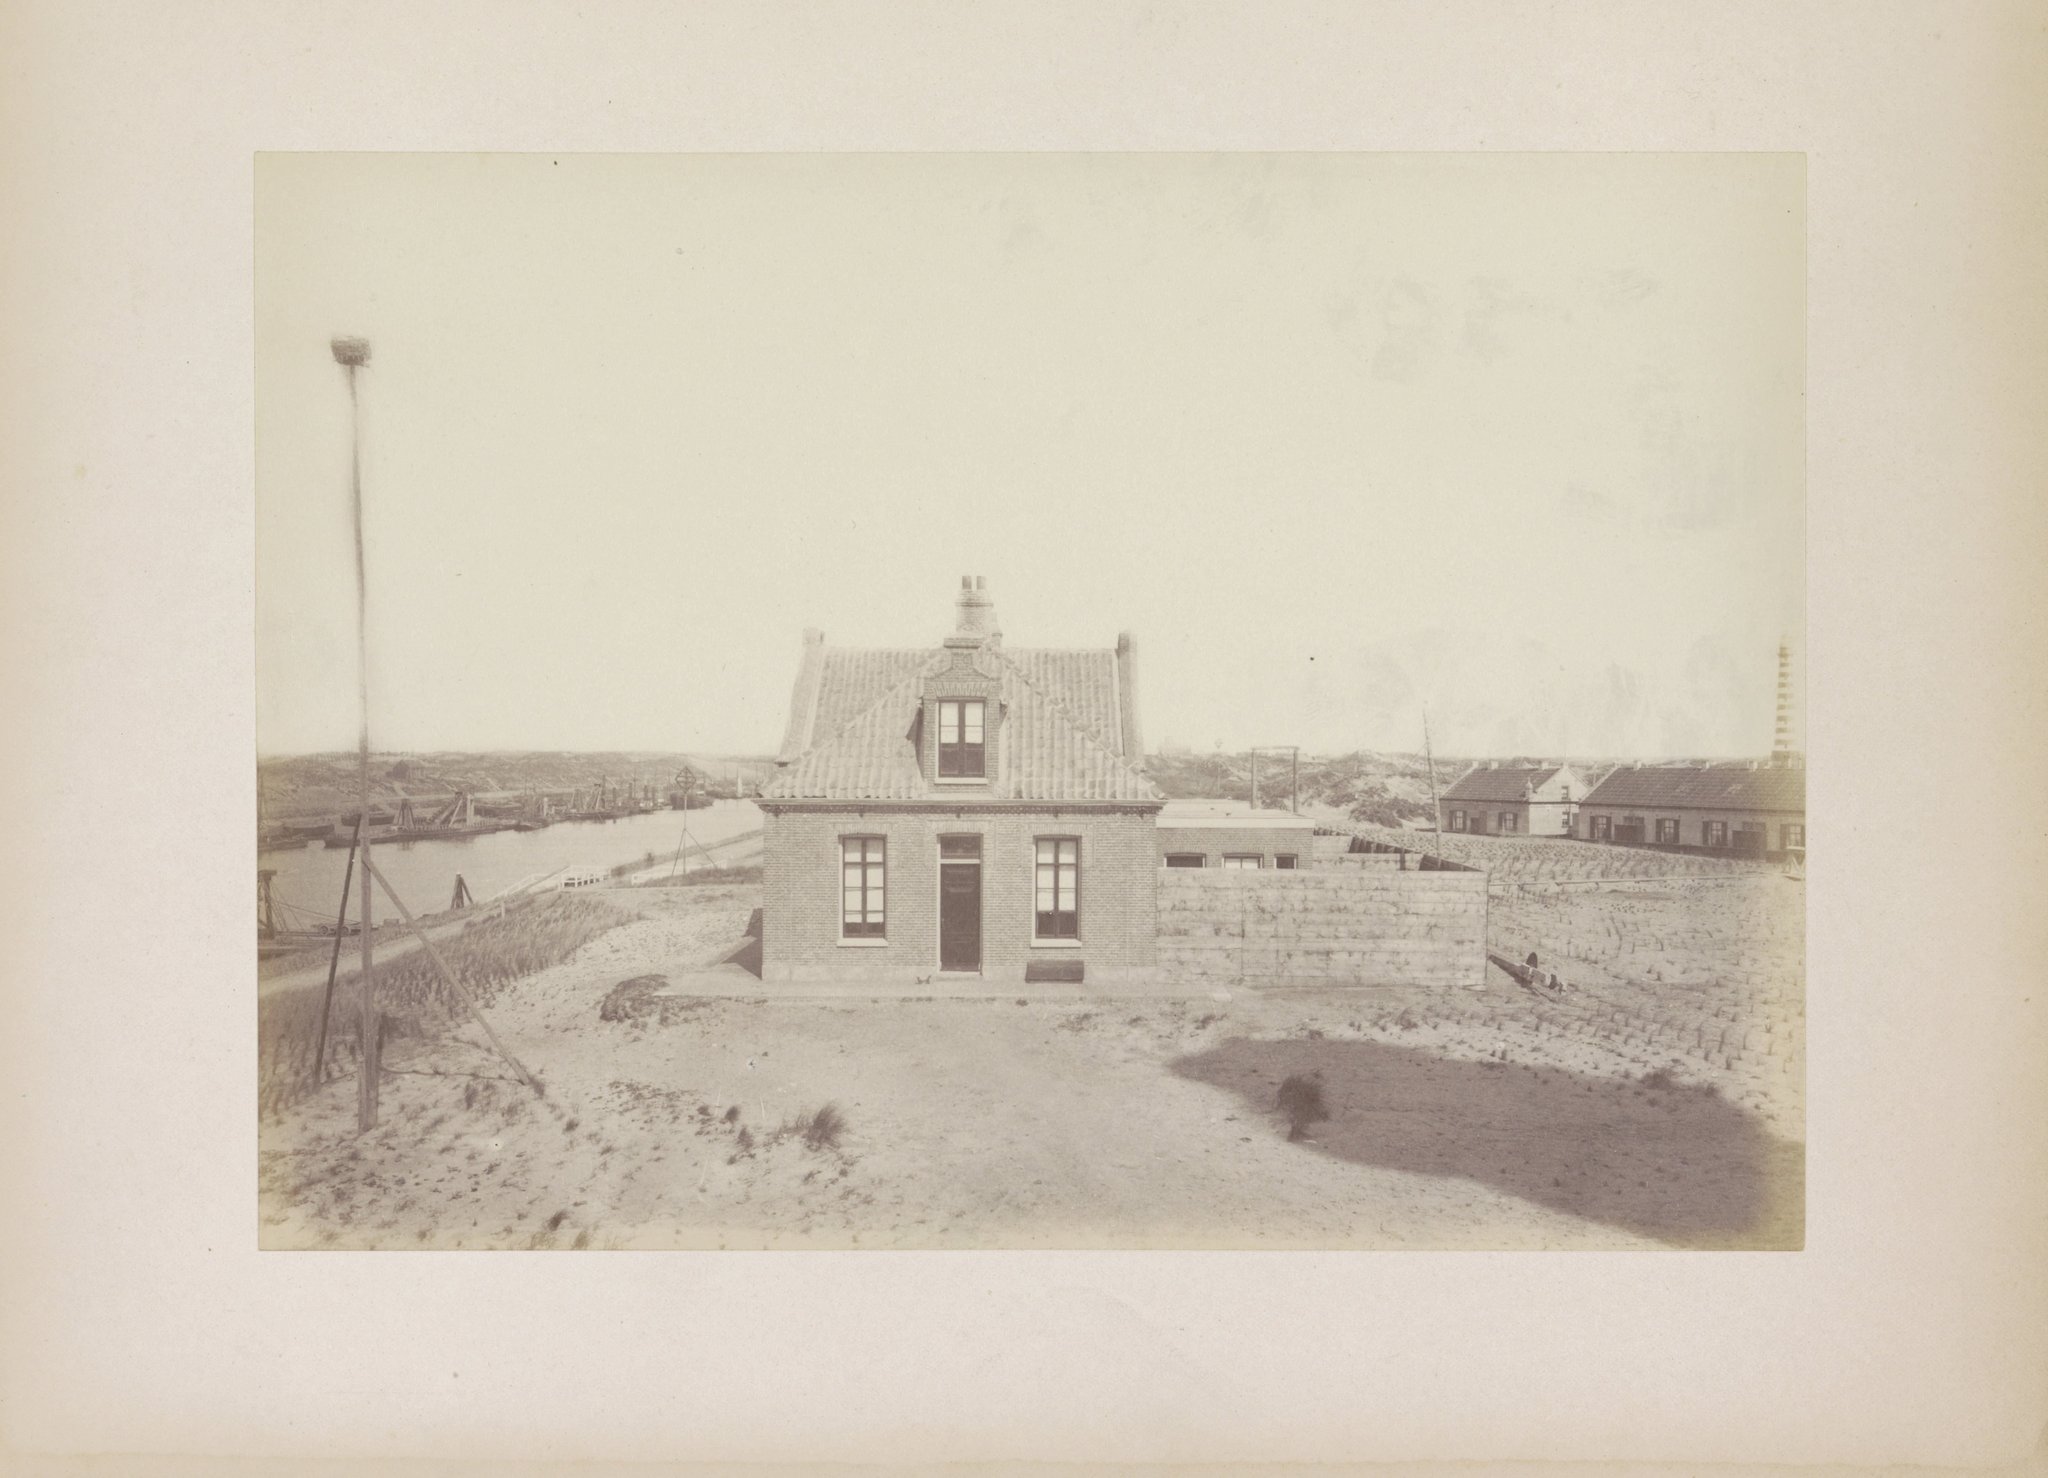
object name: photograph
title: Het dorp IJmuiden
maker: Anonymous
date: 1885-1900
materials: paper, photographic support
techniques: albumen print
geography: france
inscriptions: annotation: ‘a IJmuiden / Hollande’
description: Stenen huizen van het dorp IJmuiden in de duinen bij de haven, Nederland. Links het Noordzeekanaal en geheel rechts de vuurtoren.